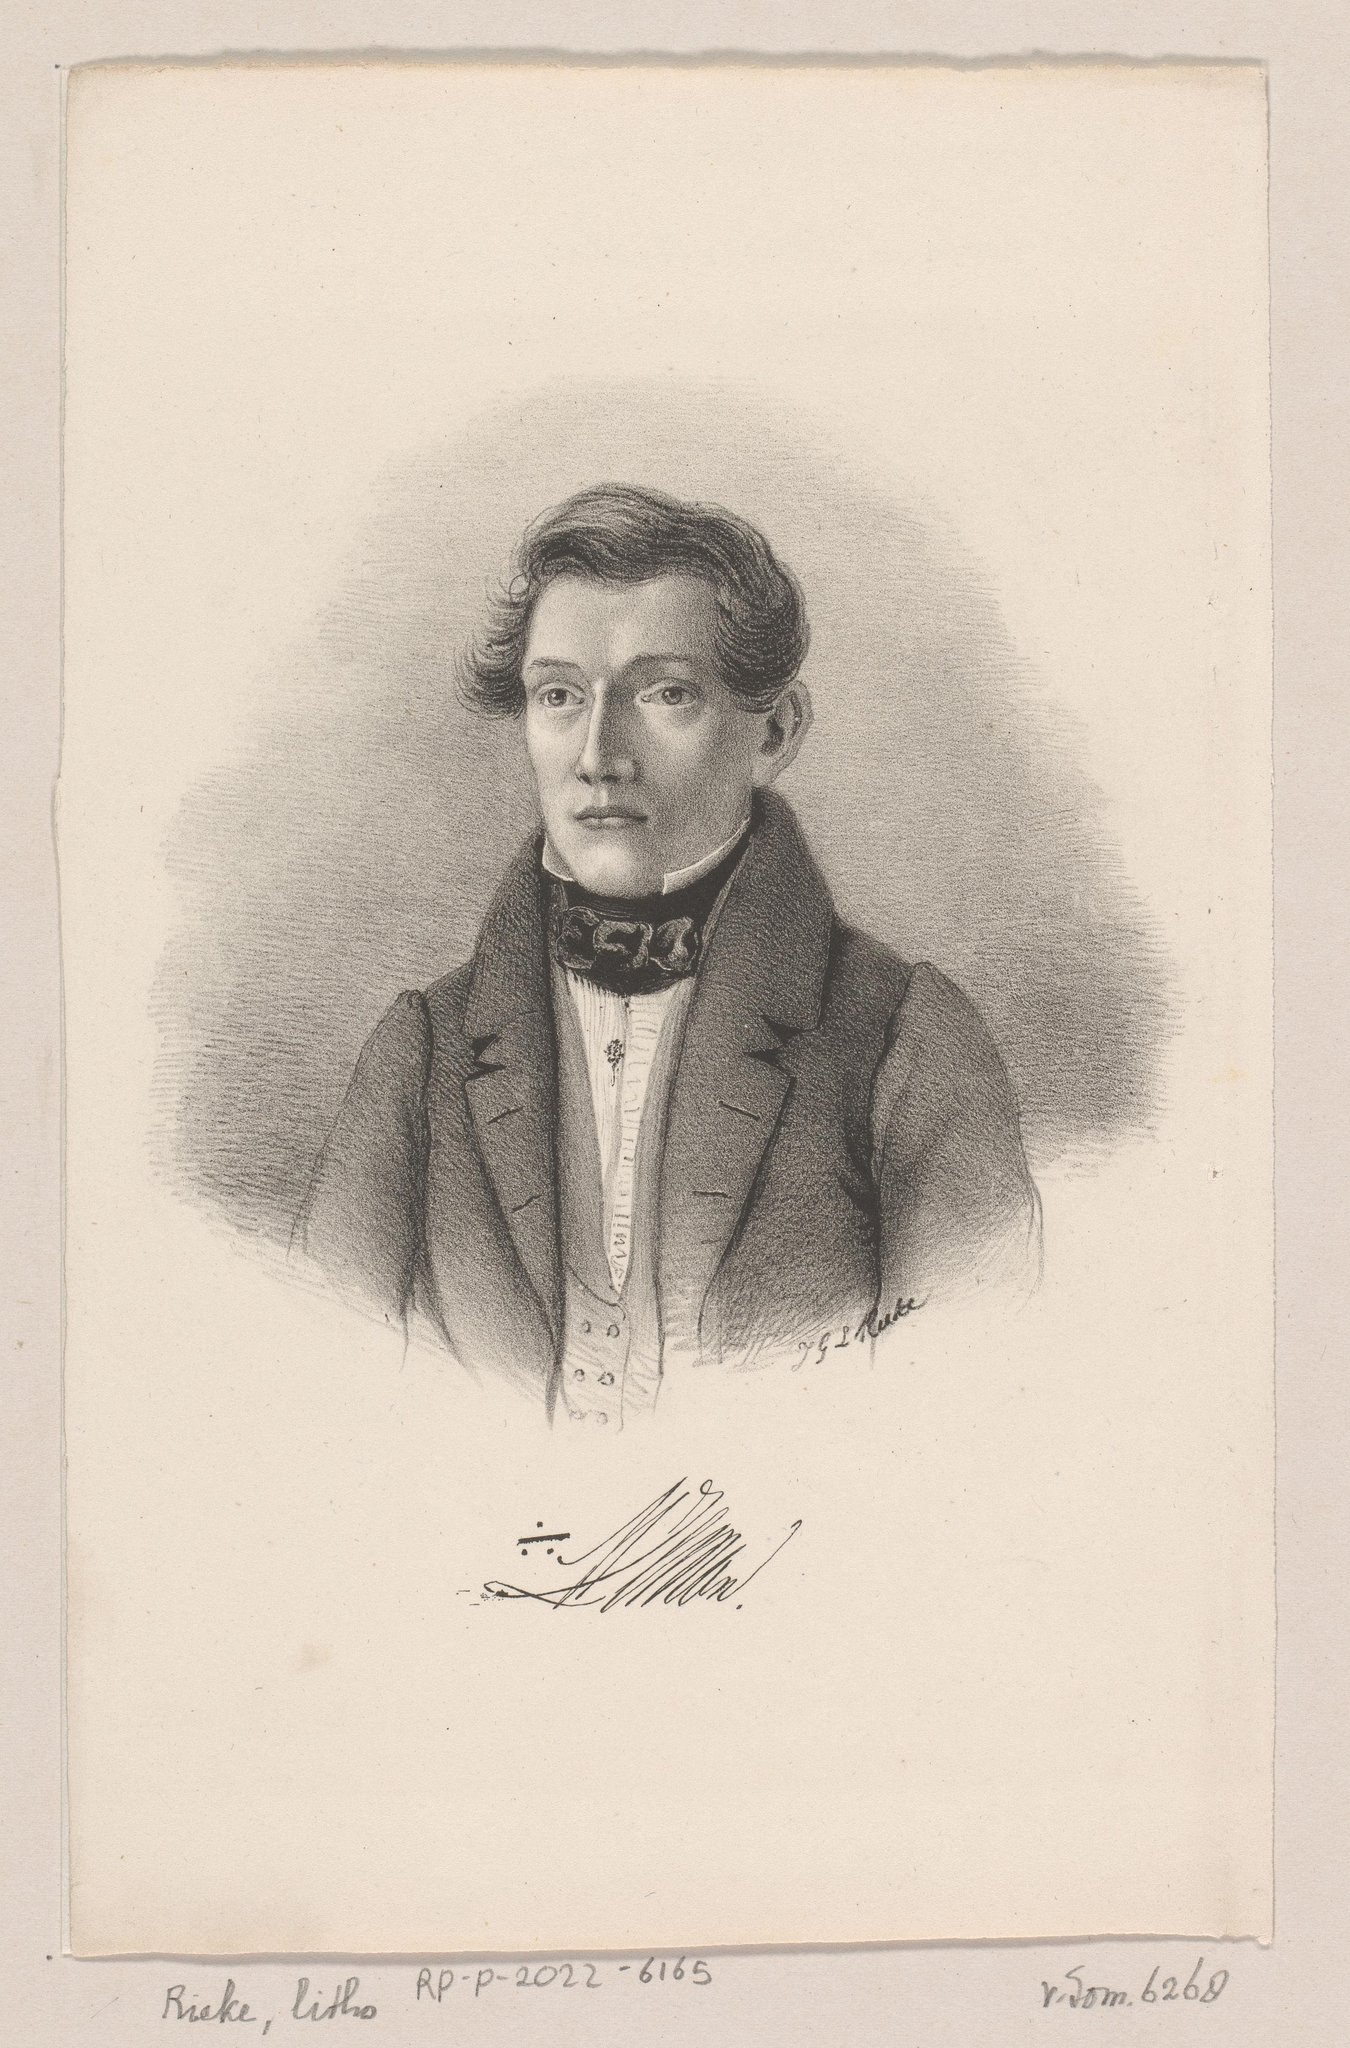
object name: print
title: Portret van Henri Zeeman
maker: johan george lodewijk rieke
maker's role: draughtsman, print maker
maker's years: 1817-1898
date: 1831-1891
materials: paper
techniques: lithograph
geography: amsterdam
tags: amsterdam, historical persons, portrait of a writer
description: Met facsimile handtekening van de geportretteerde.